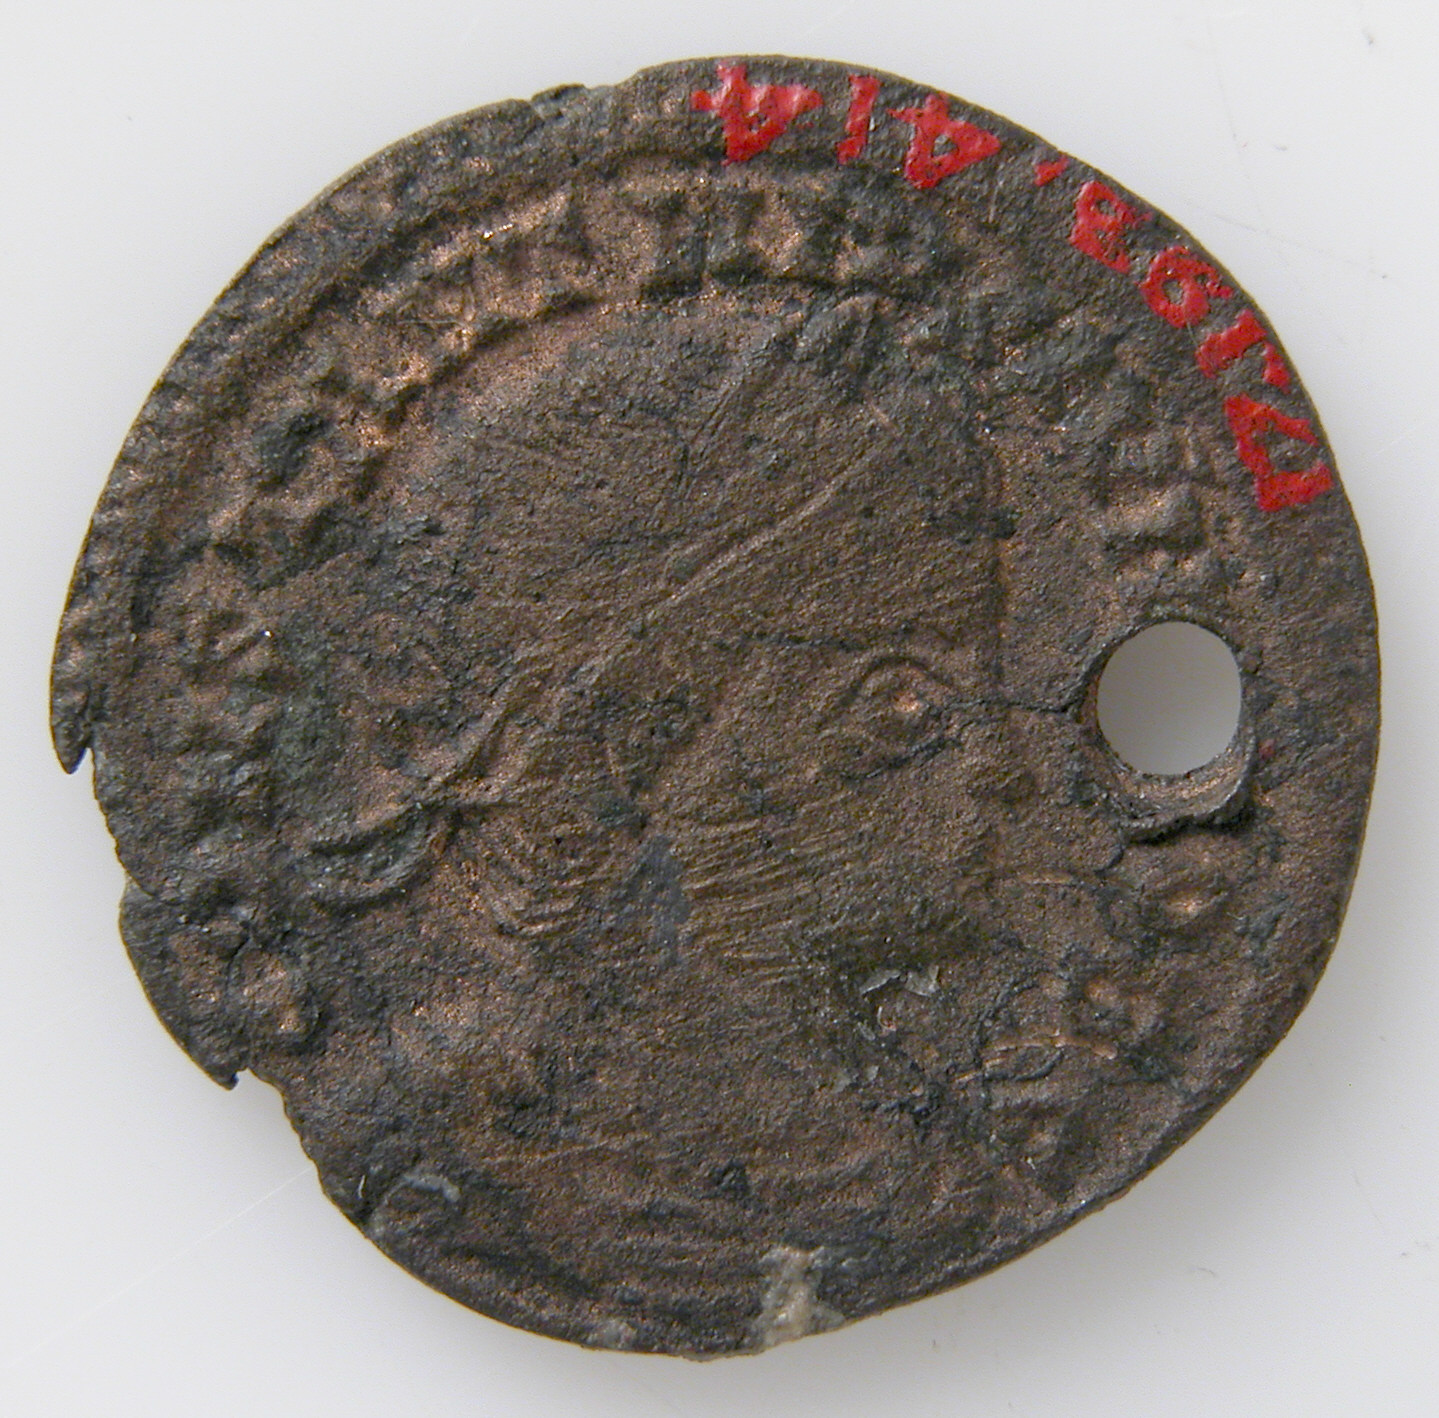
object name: coin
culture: byzantine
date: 301-400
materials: copper alloy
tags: profiles